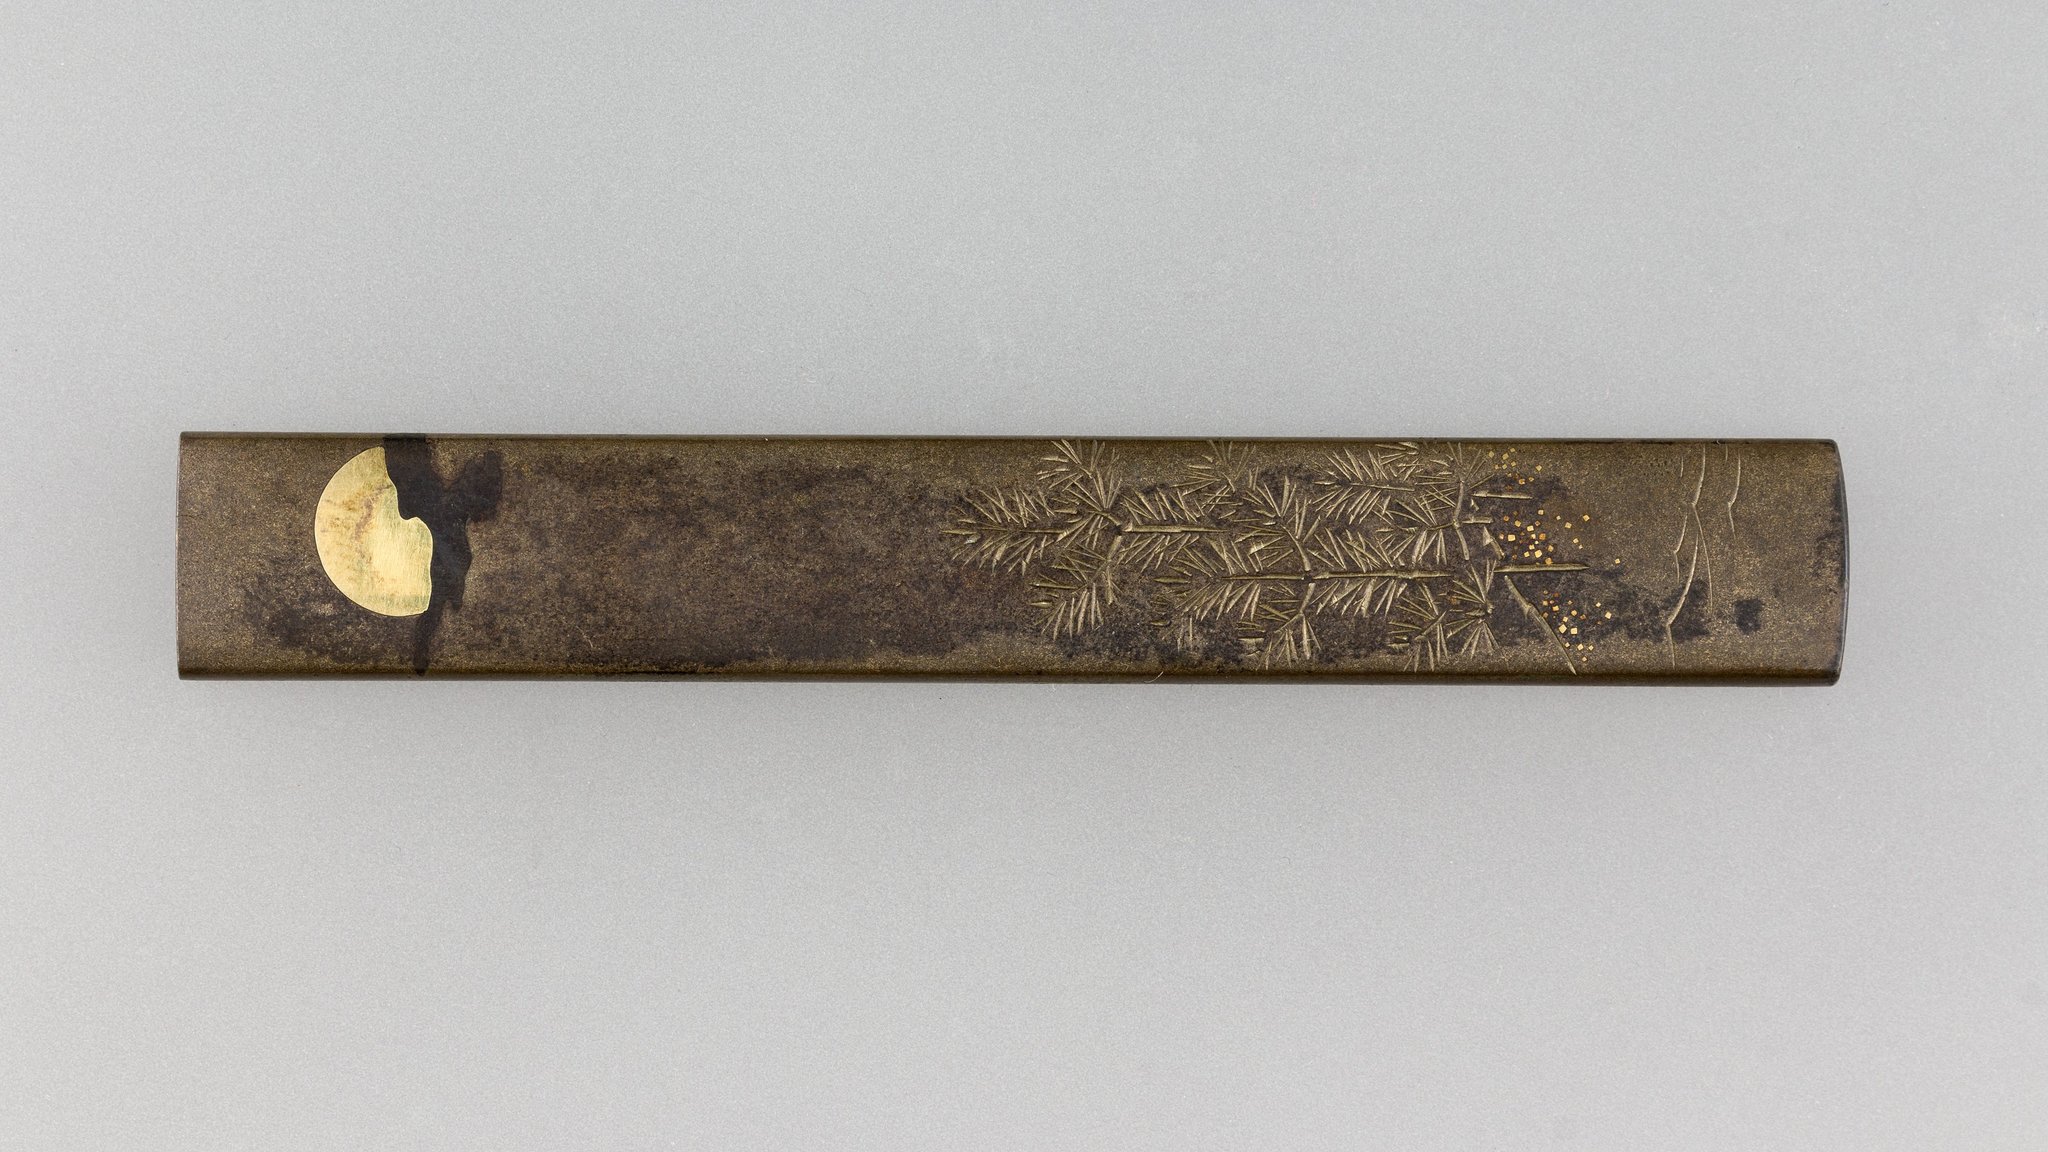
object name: knife handle kozuka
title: Knife Handle (Kozuka)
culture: japanese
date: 1801-1900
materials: gold alloy, silver alloy, gold, silver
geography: japan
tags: trees